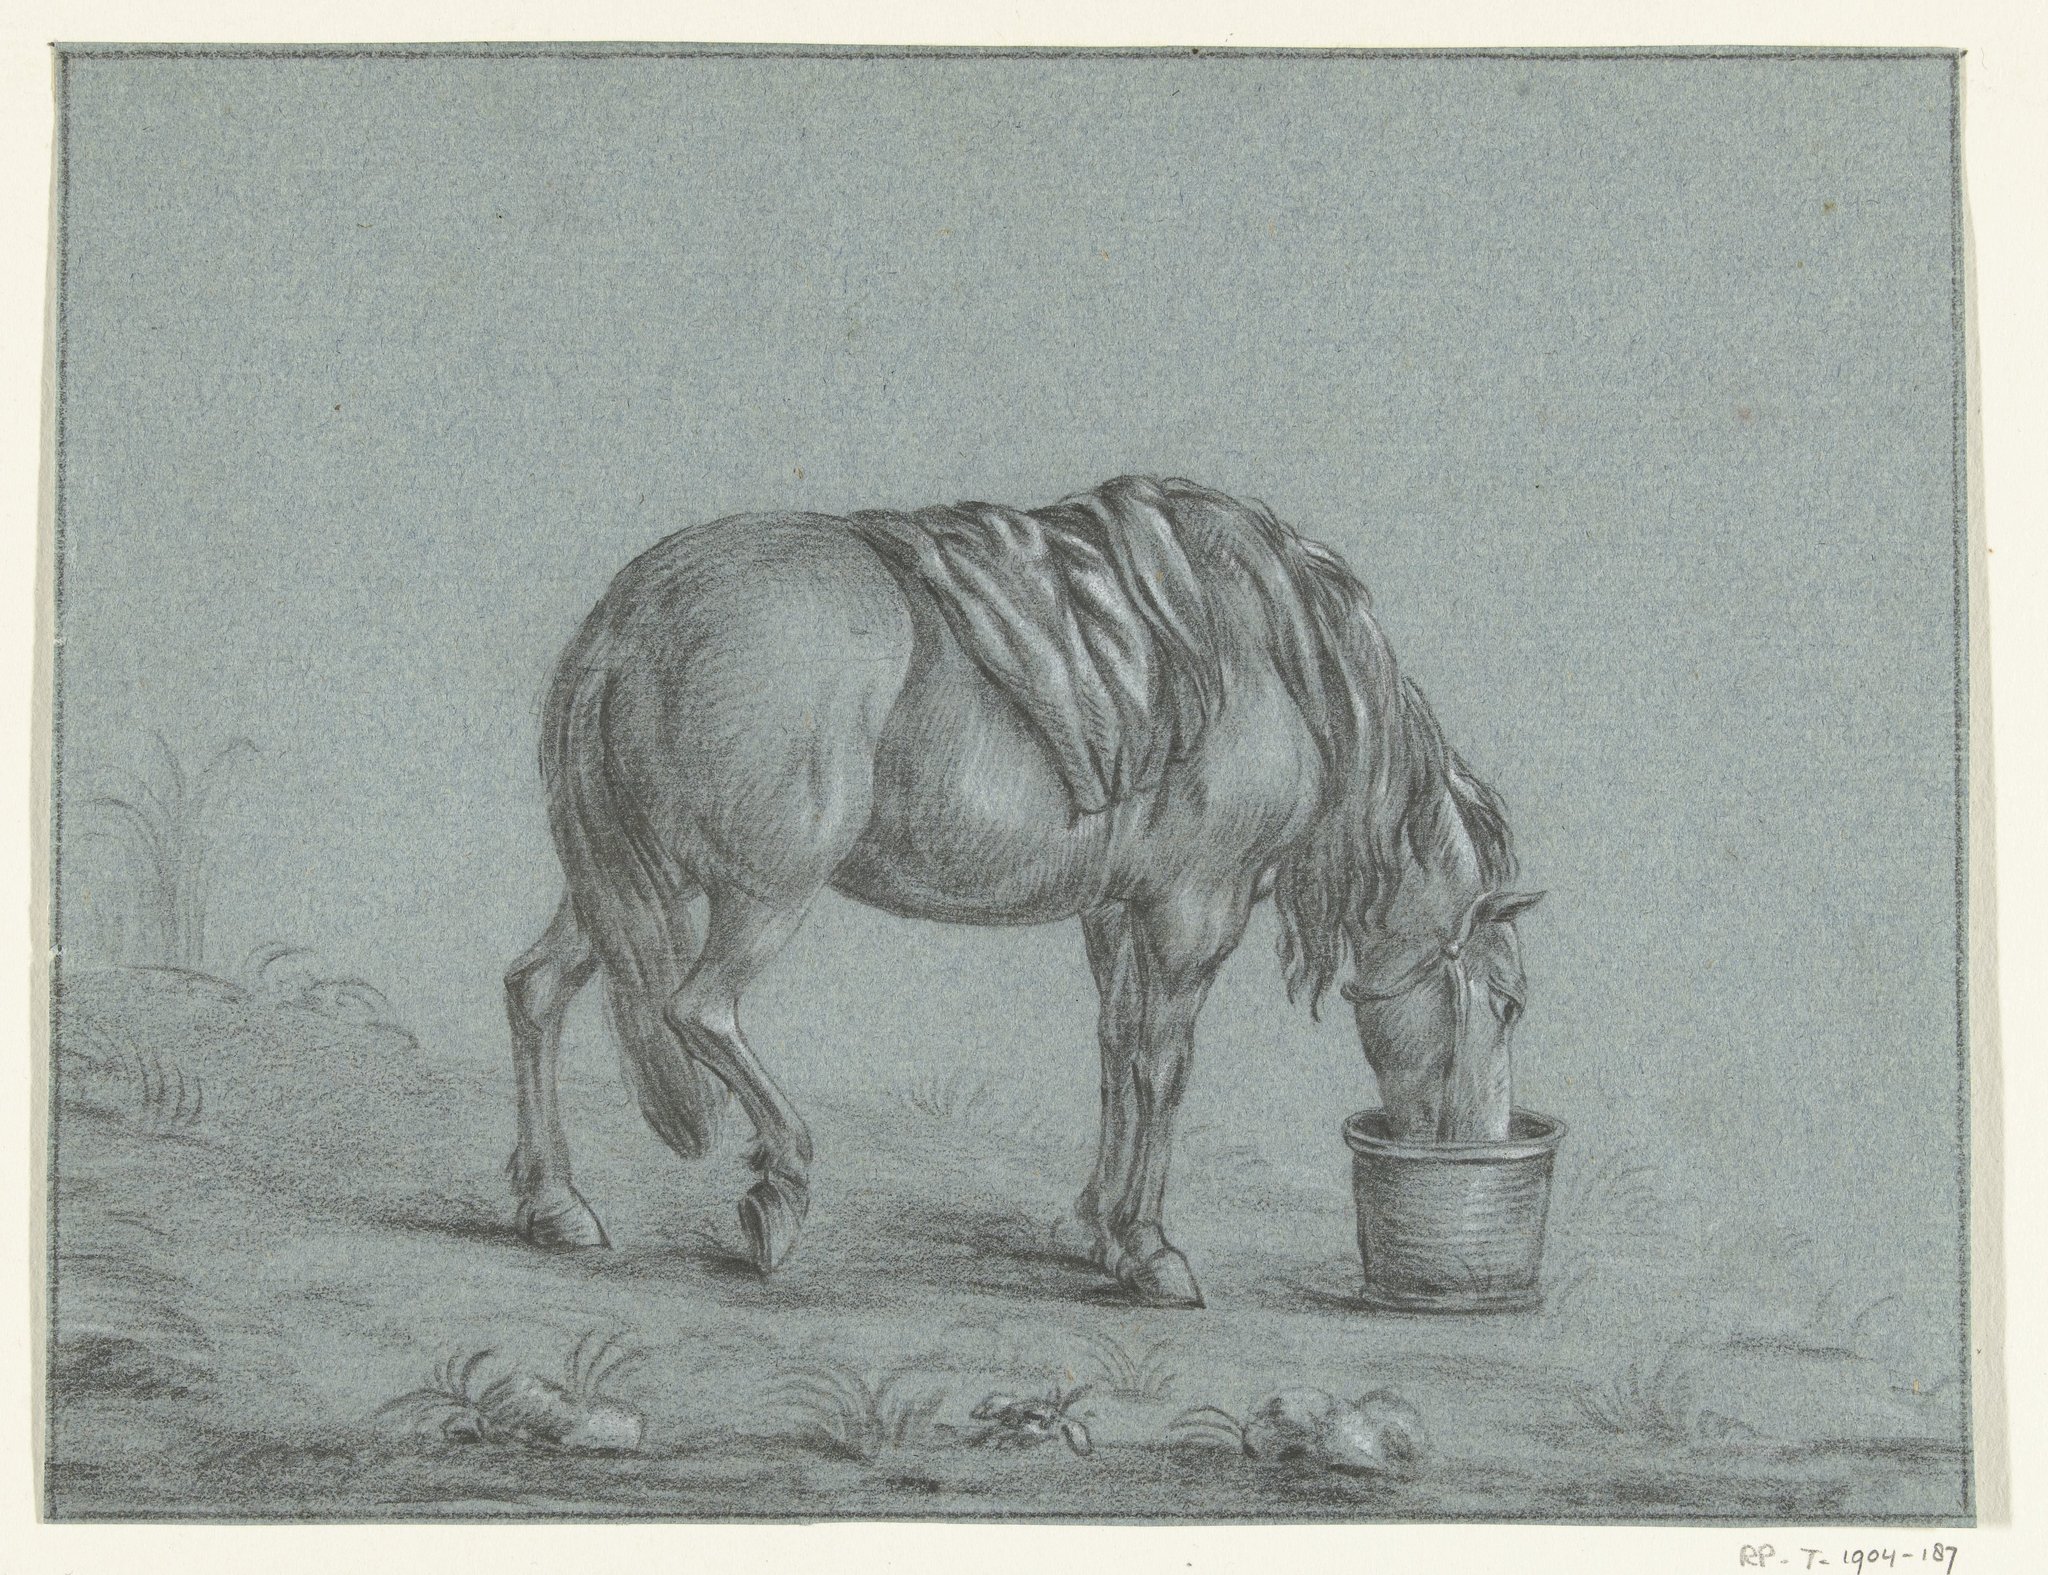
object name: drawing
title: Paard etend uit een bak, naar rechts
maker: jean bernard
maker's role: draughtsman, print maker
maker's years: 1765-1833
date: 1775-1833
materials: chalk, paper, pencil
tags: horse